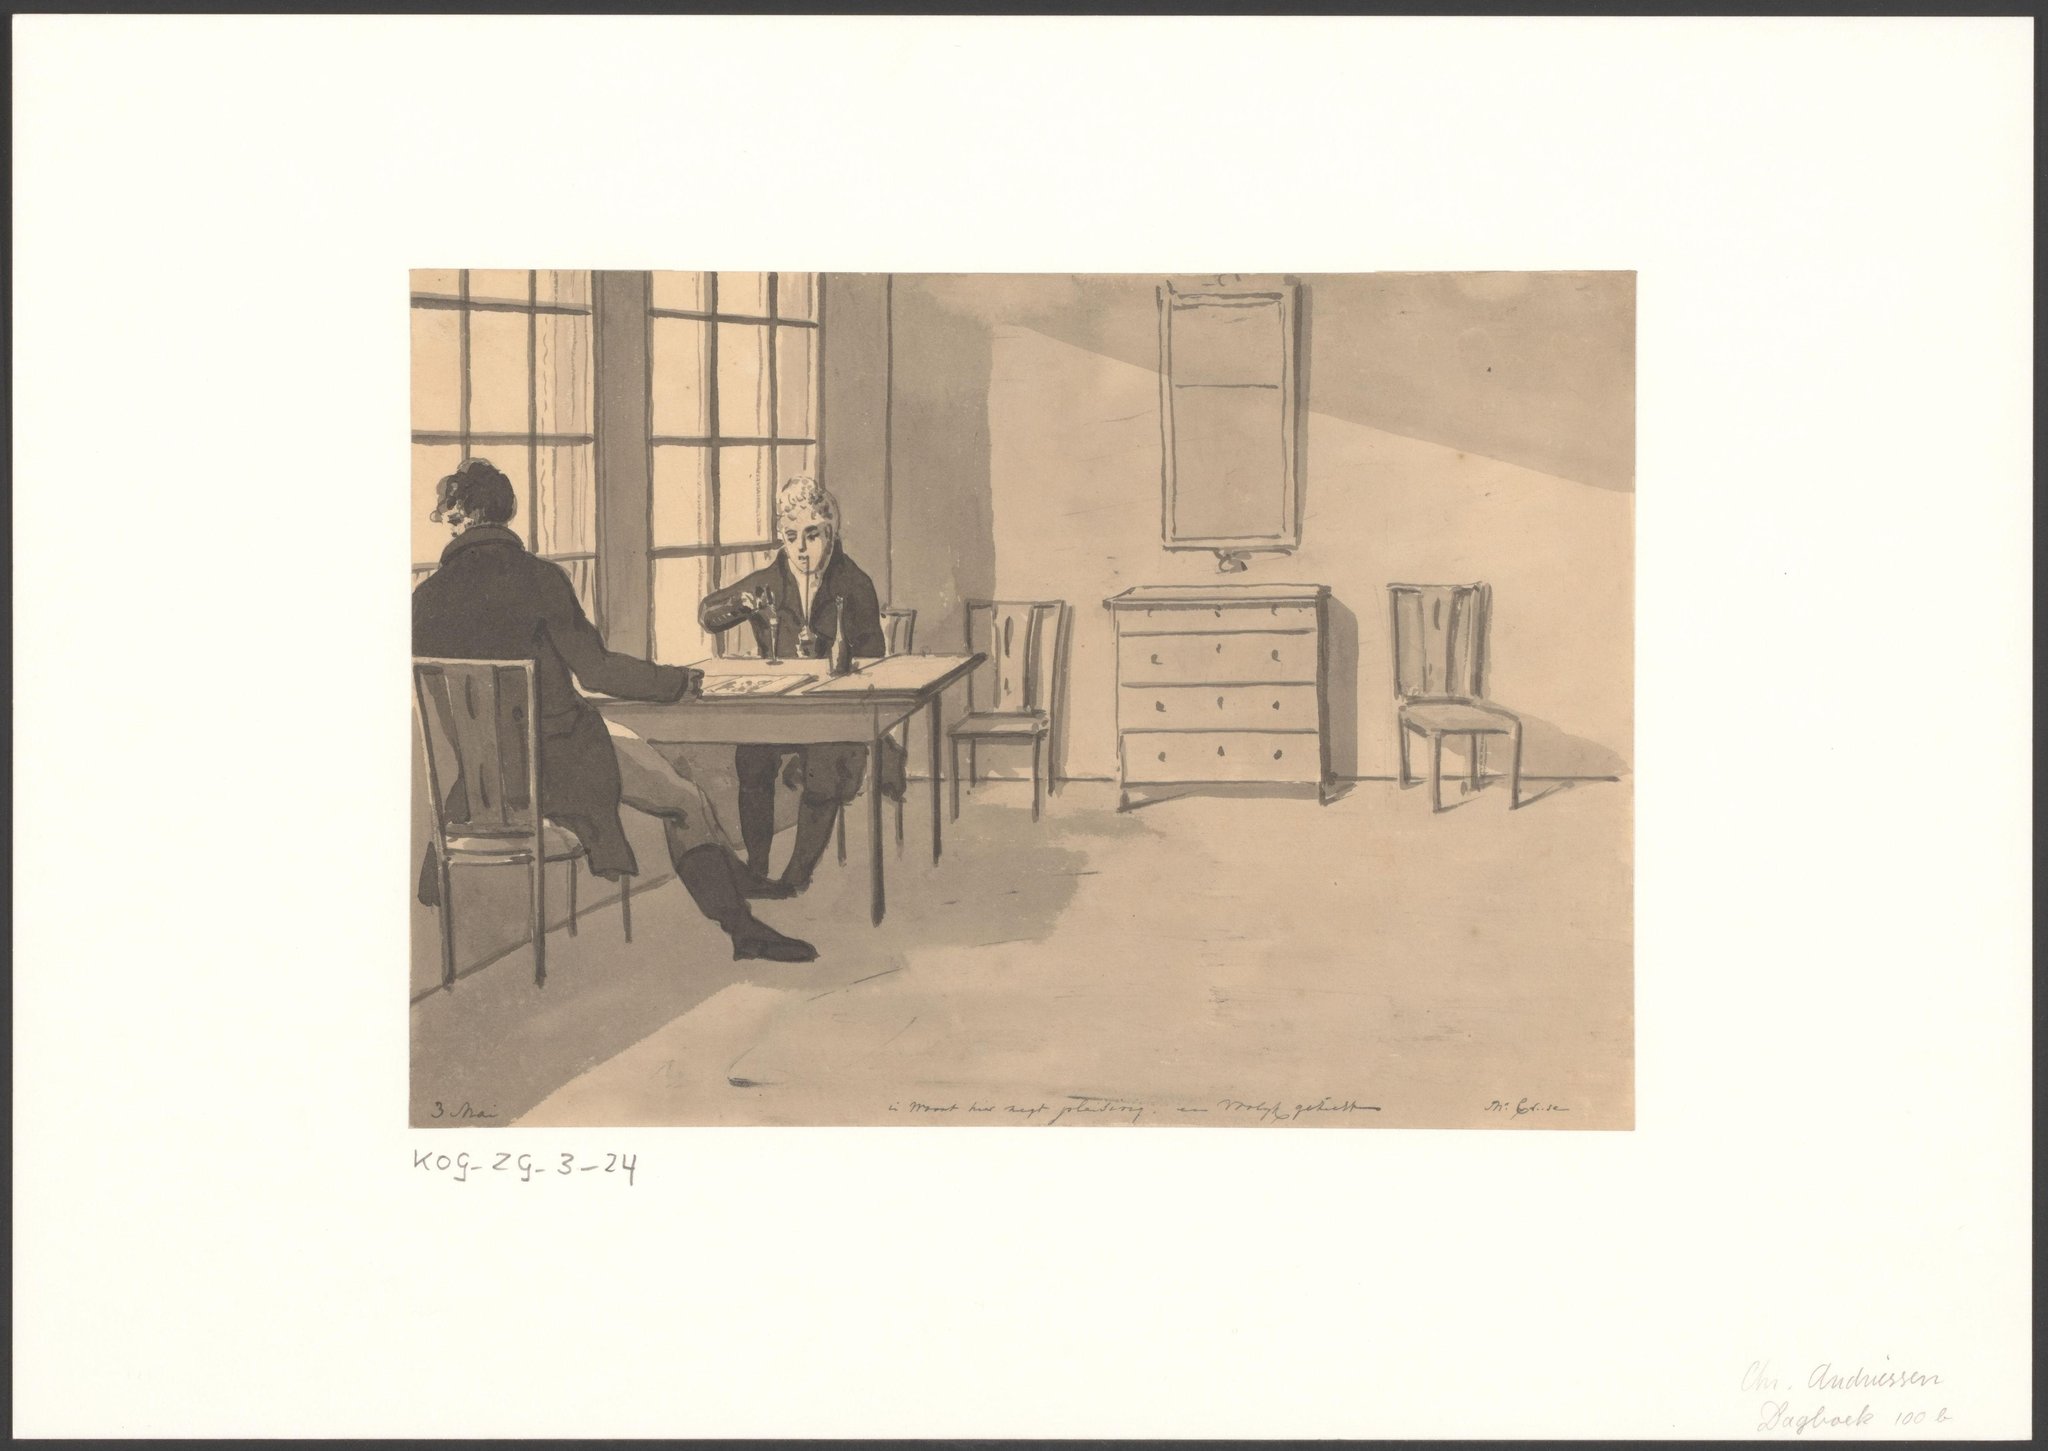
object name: drawing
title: Christiaan Andriessen aan tafel met een andere man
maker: christiaan andriessen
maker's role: draughtsman, print maker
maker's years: 1775-1846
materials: ink, paper, pencil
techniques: brush, pen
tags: window, glass of wine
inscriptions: inscription: ‘J Andriessen’, inscription: ‘je woont hier regt pleizirig, een vrolijk gezicht’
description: Dagboekblad uit het getekende dagboek dat Christiaan Andriessen bijhield van 1805 tot en met 1808.